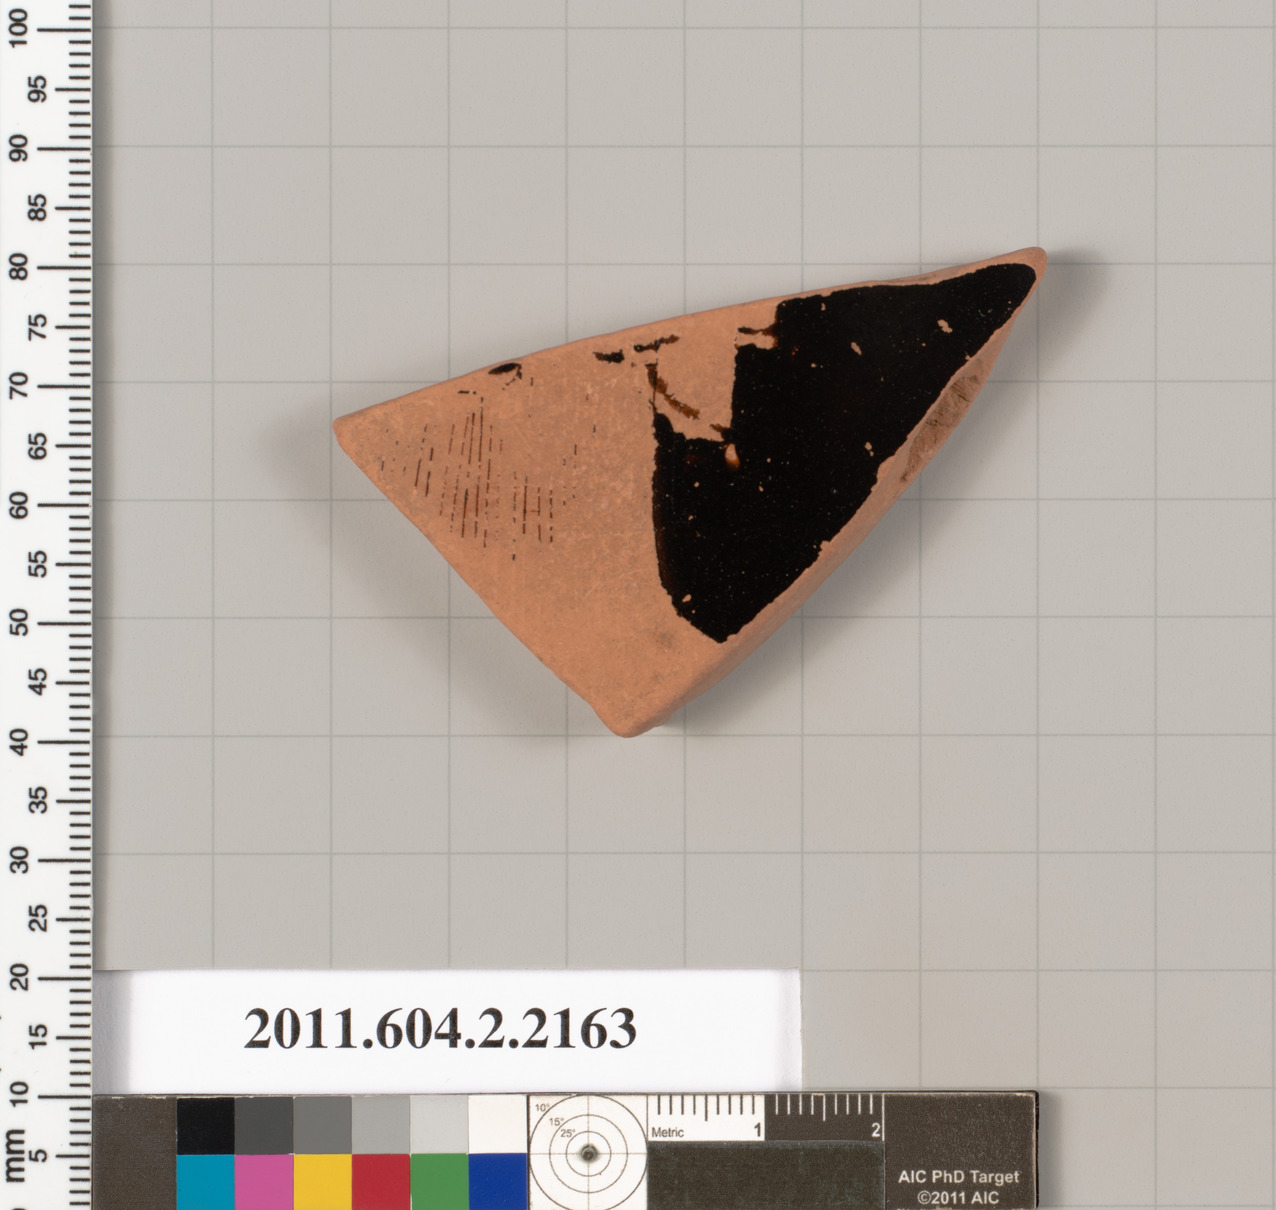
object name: pot fragment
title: Terracotta fragment of a pot; unglazed on the inside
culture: greek, attic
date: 475-451 BCE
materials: terracotta